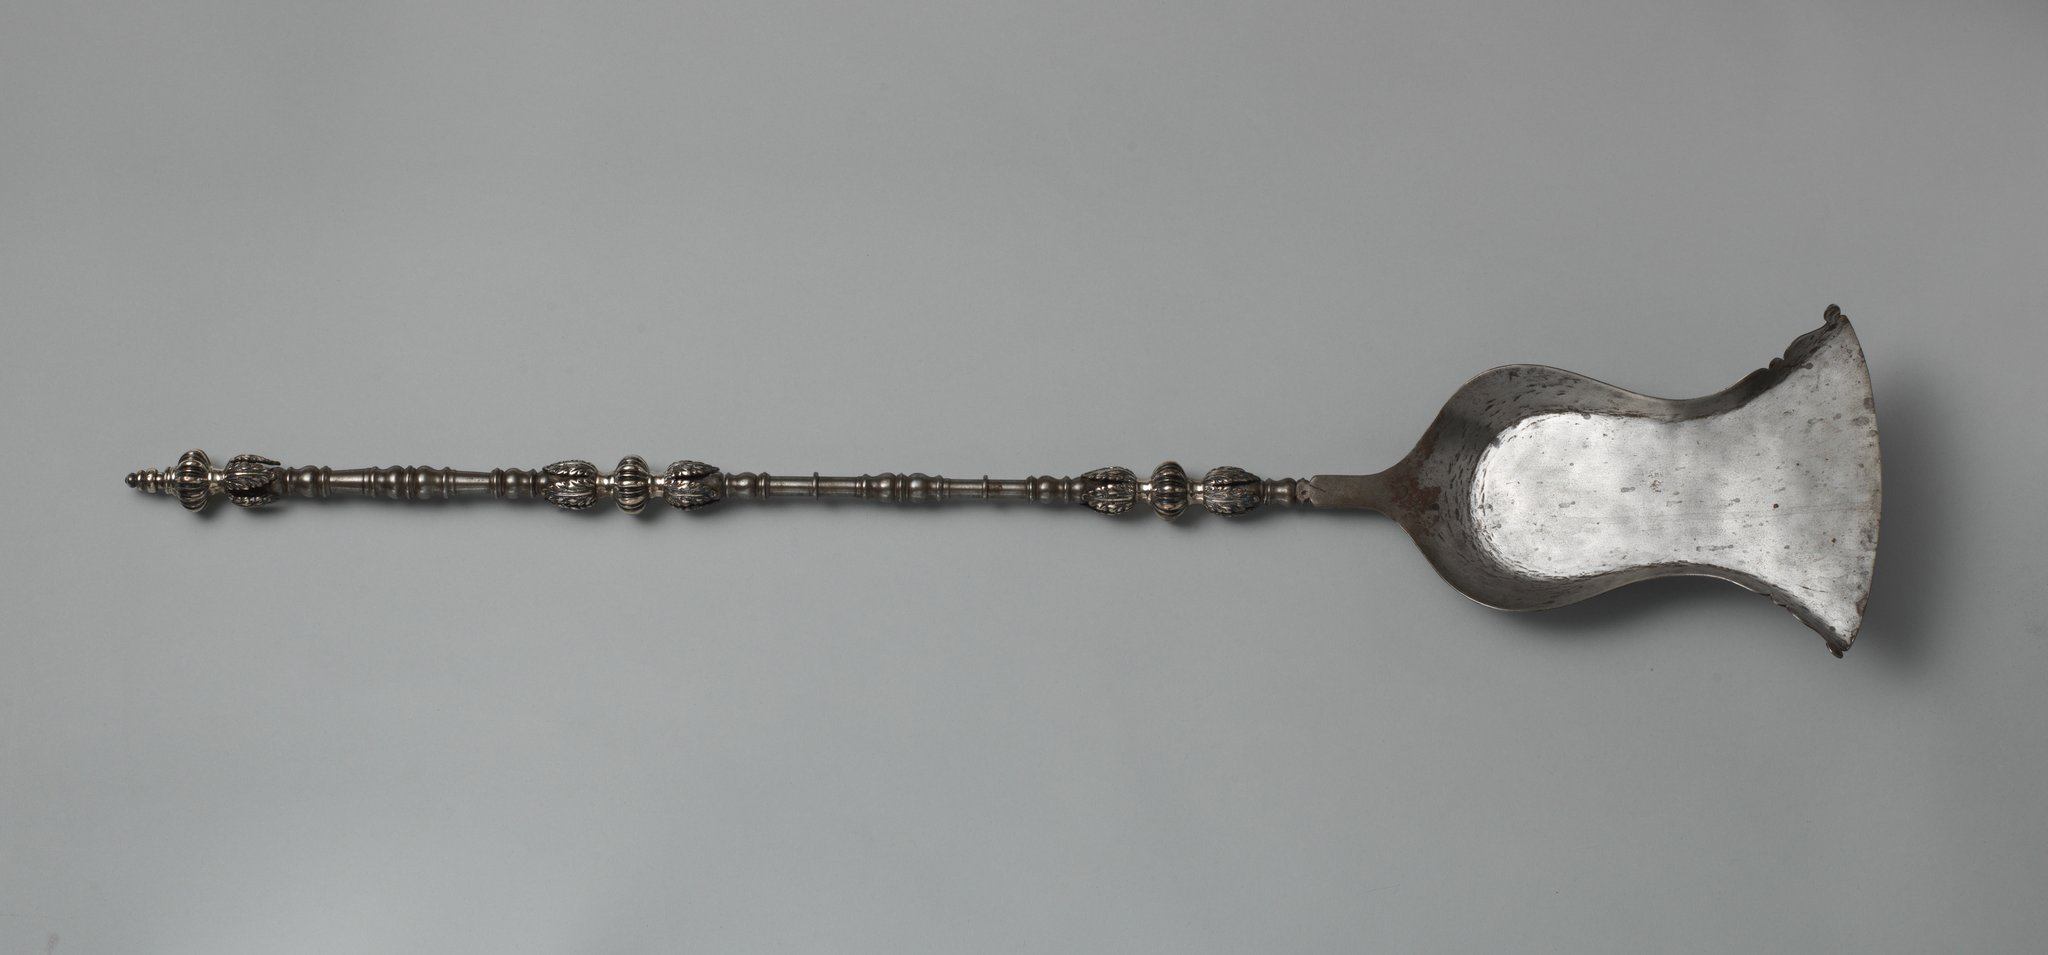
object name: shovel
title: Shovel (part of a set)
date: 1675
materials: iron, silver